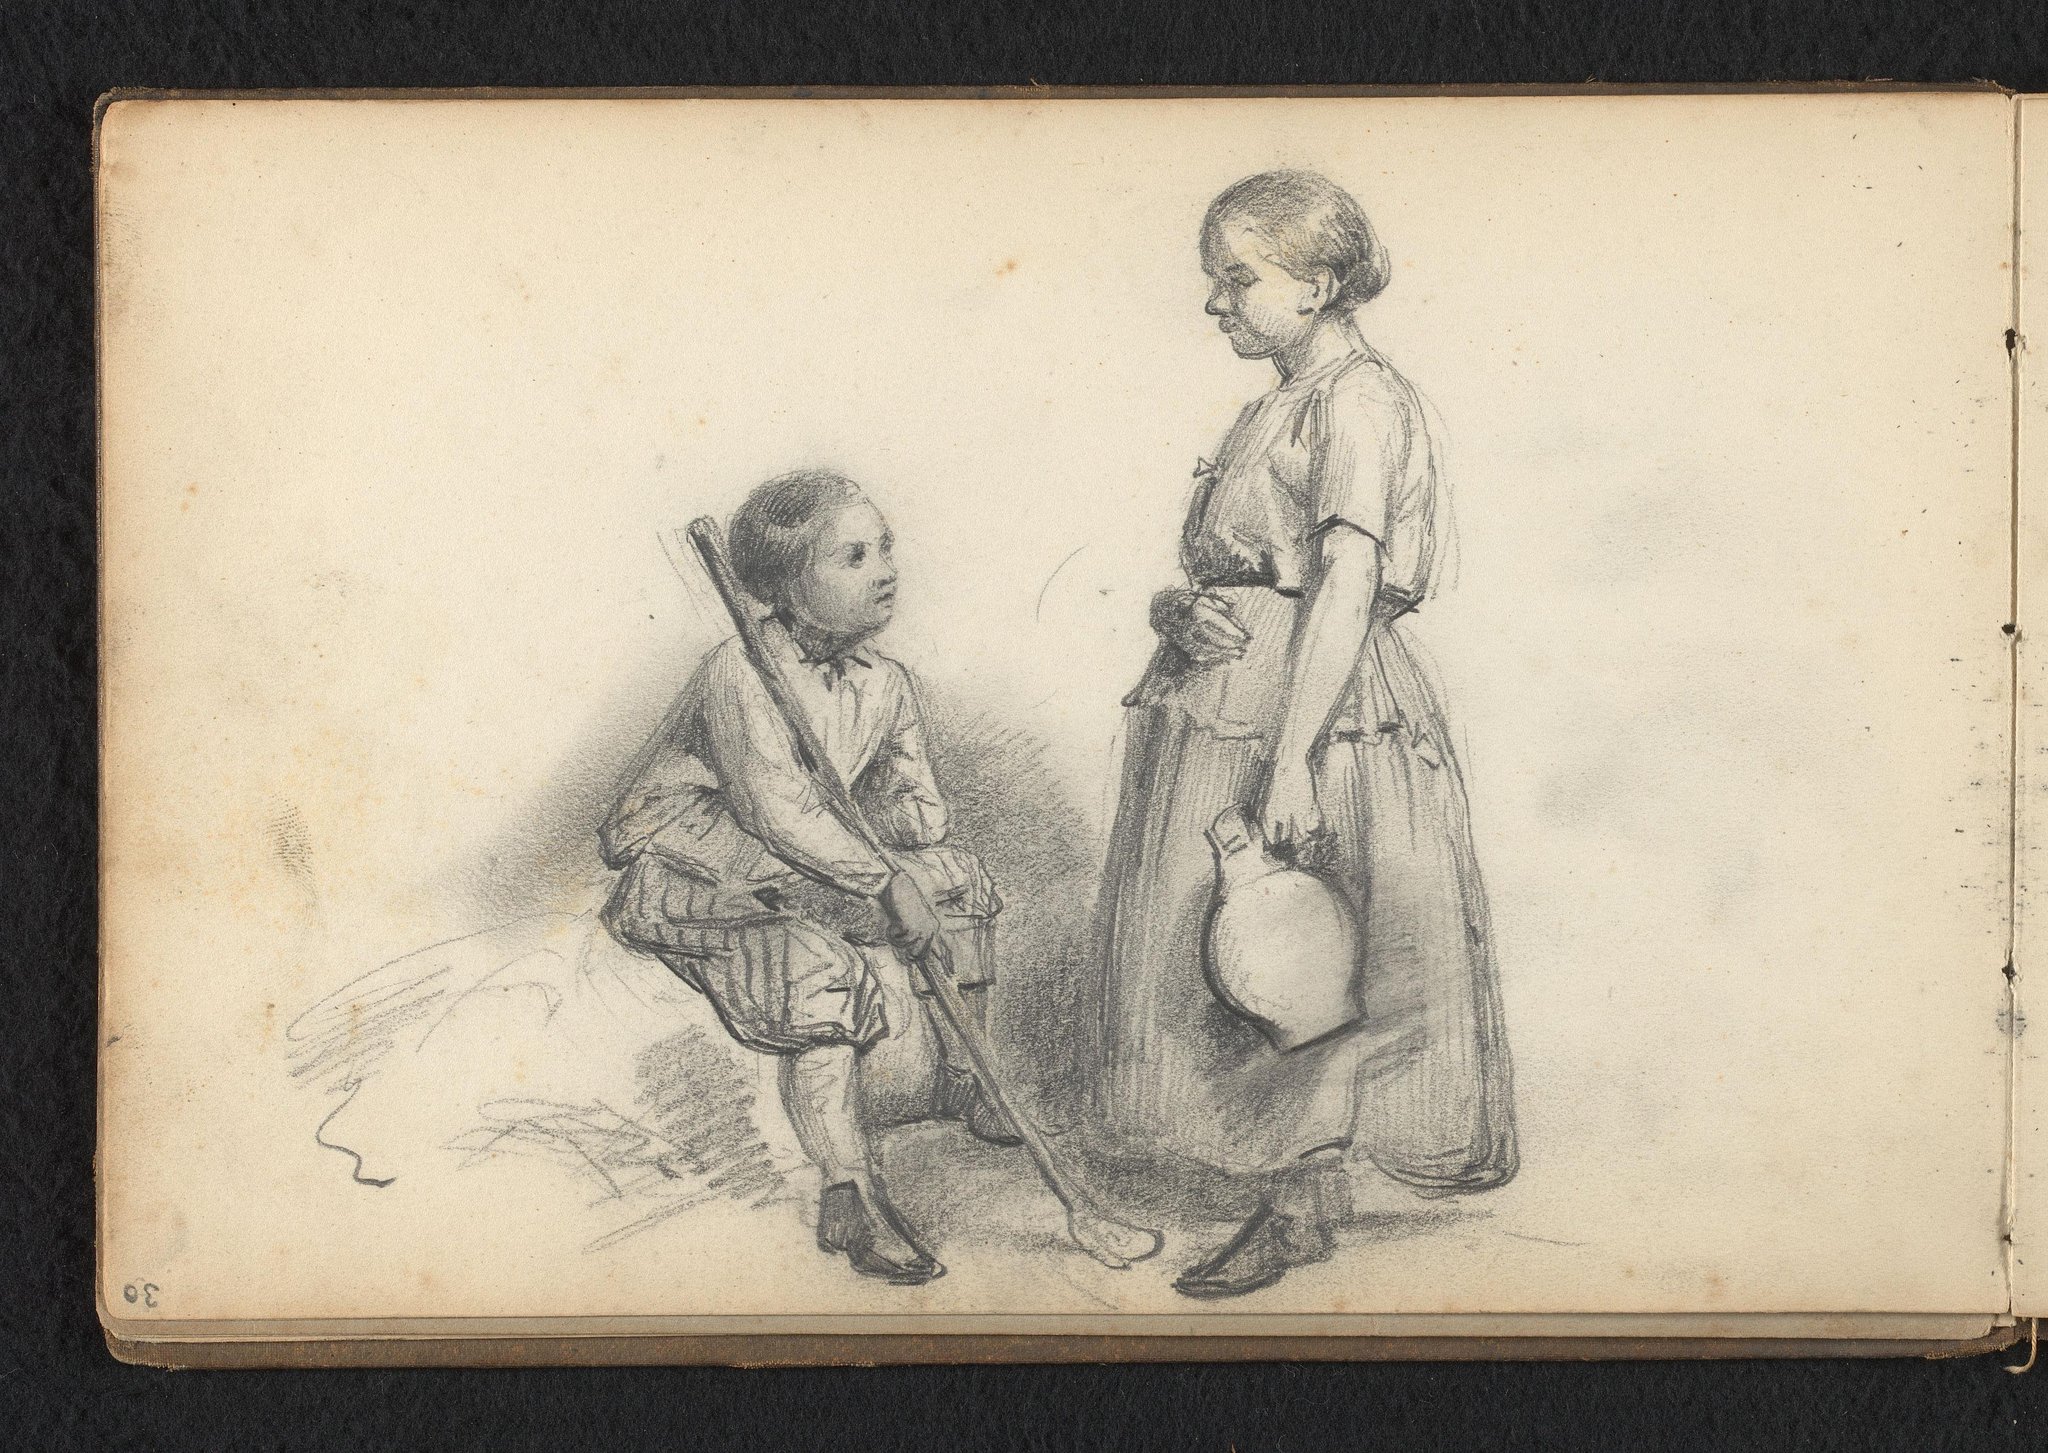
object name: sketchbook leaf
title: Twee kinderen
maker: jan bedijs tom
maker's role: draughtsman, painter, print maker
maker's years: 1813-1894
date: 1823-1894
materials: paper, pencil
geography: the hague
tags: boy (child between toddler and youth), girl (child between toddler and youth), container of ceramics: jar, jug, pot, vase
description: Pagina 30 recto uit een schetsboek met 37 bladen.